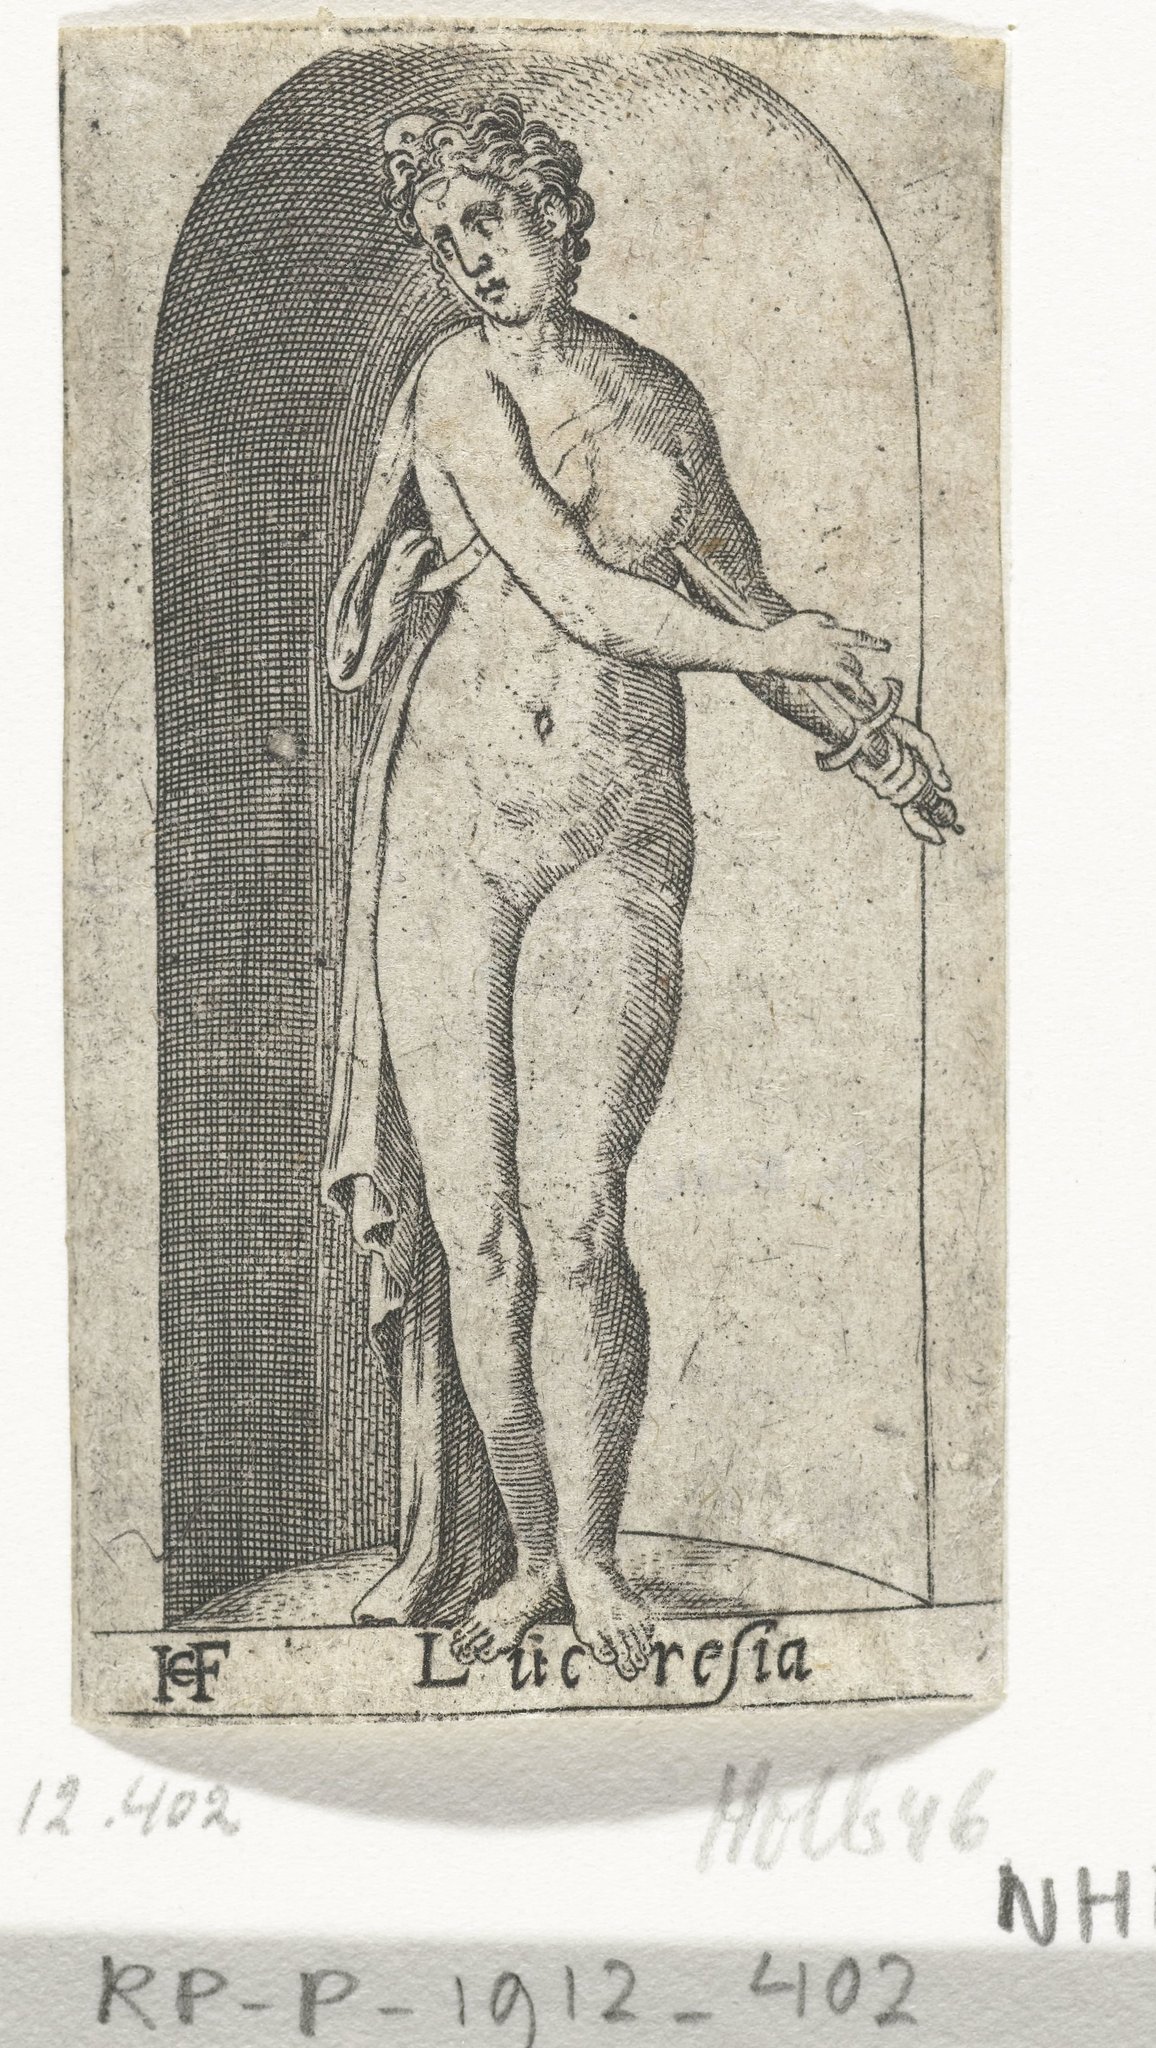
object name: print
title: Lucretia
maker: hans collaert (i)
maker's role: draughtsman, print maker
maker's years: 1520-1581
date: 1530-1580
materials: paper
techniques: engraving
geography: antwerp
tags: (story of) lucretia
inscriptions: collector's mark: Lugt 2241, collector's mark: Lugt 2228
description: De naakte Lucretia in een nis. Ze staat op het punt zich te doorsteken met een dolk. De prent is deel van een serie met ontwerpen van bekende personen uit de Bijbel, de mythologie en de Oudheid als onderwerp.